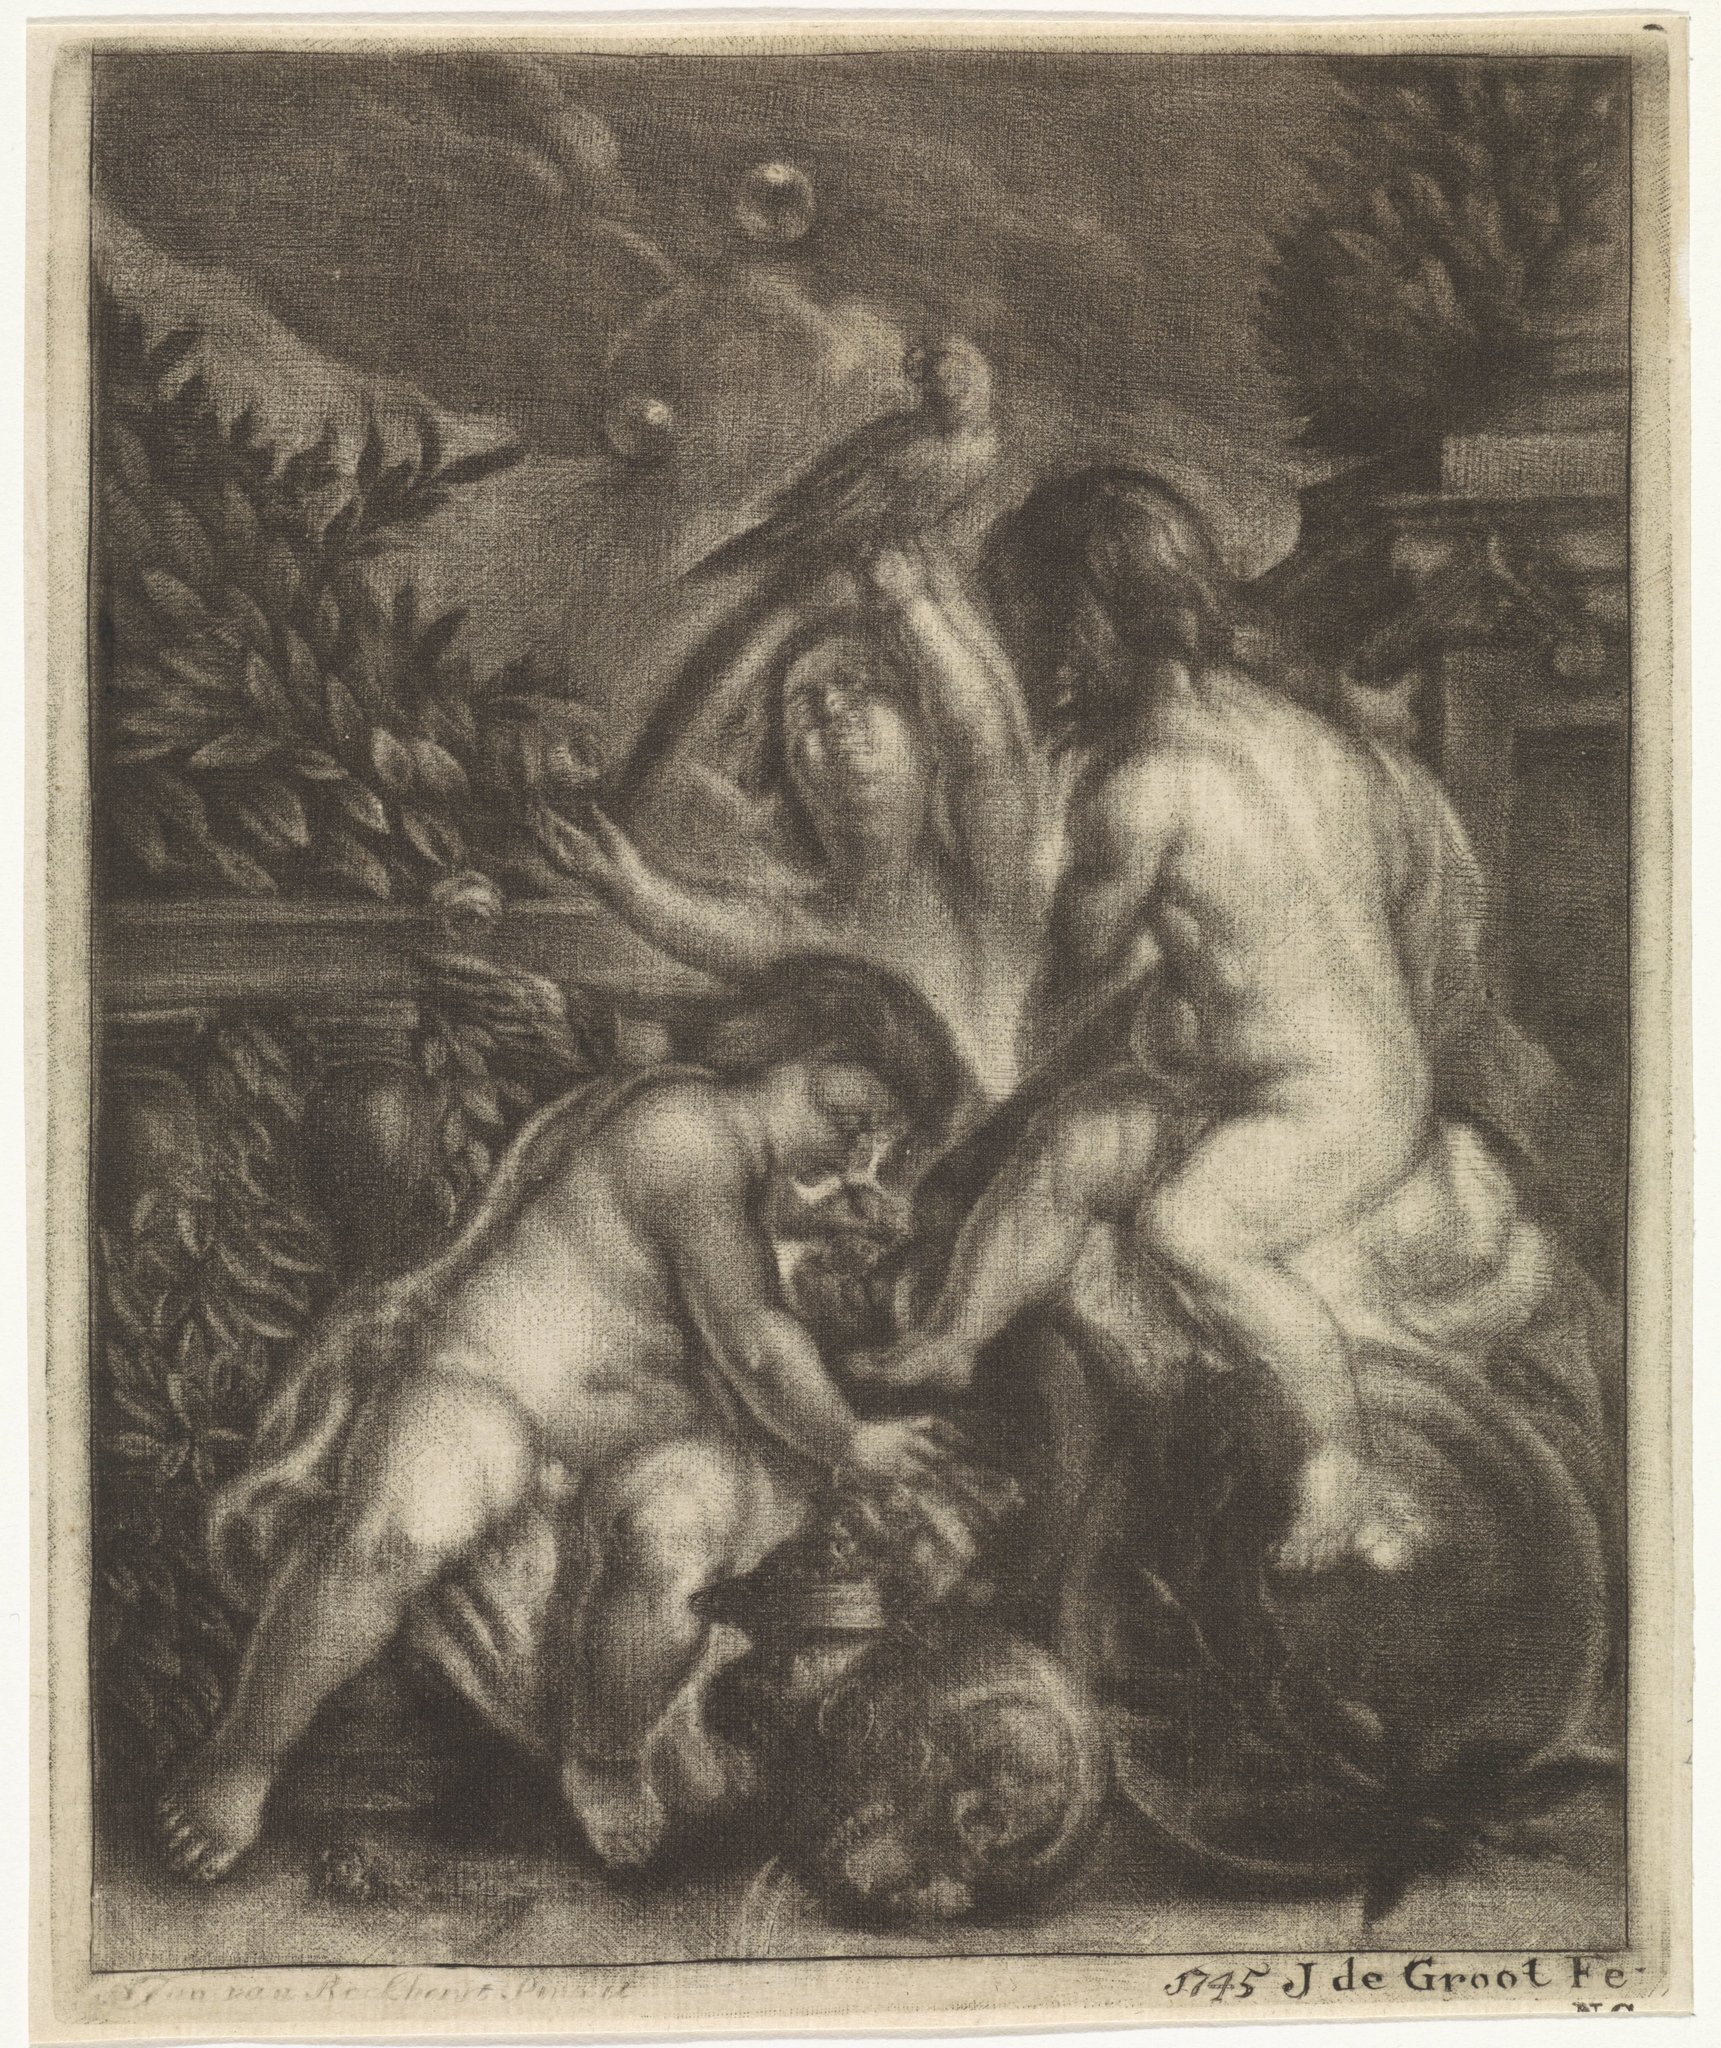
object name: print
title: Allegorie op de vergankelijkheid (Vanitas)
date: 1745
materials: paper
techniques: engraving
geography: northern netherlands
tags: ornamental birds: parrot, 'vanitas' symbols, one person playing string instrument (plucked), lute, and special forms of lute, e.g.: theorbo, (children or putti) blowing bubbles, 'homo bulla' ~ scene symbolizing 'vanitas'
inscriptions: collector's mark: Lugt 2228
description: Allegorie op de vergankelijkheid met drie kinderen van wie er een zeepbellen blaast. Een ander houdt een papegaai vast en een derde bespeelt een luit. Op de voorgrond ligt een doodshoofd.